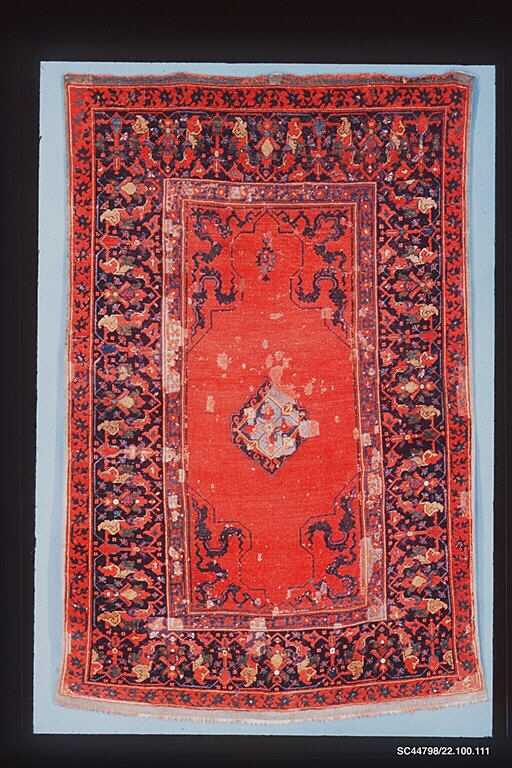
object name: carpet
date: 1501-1700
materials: wool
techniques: pile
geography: turkey